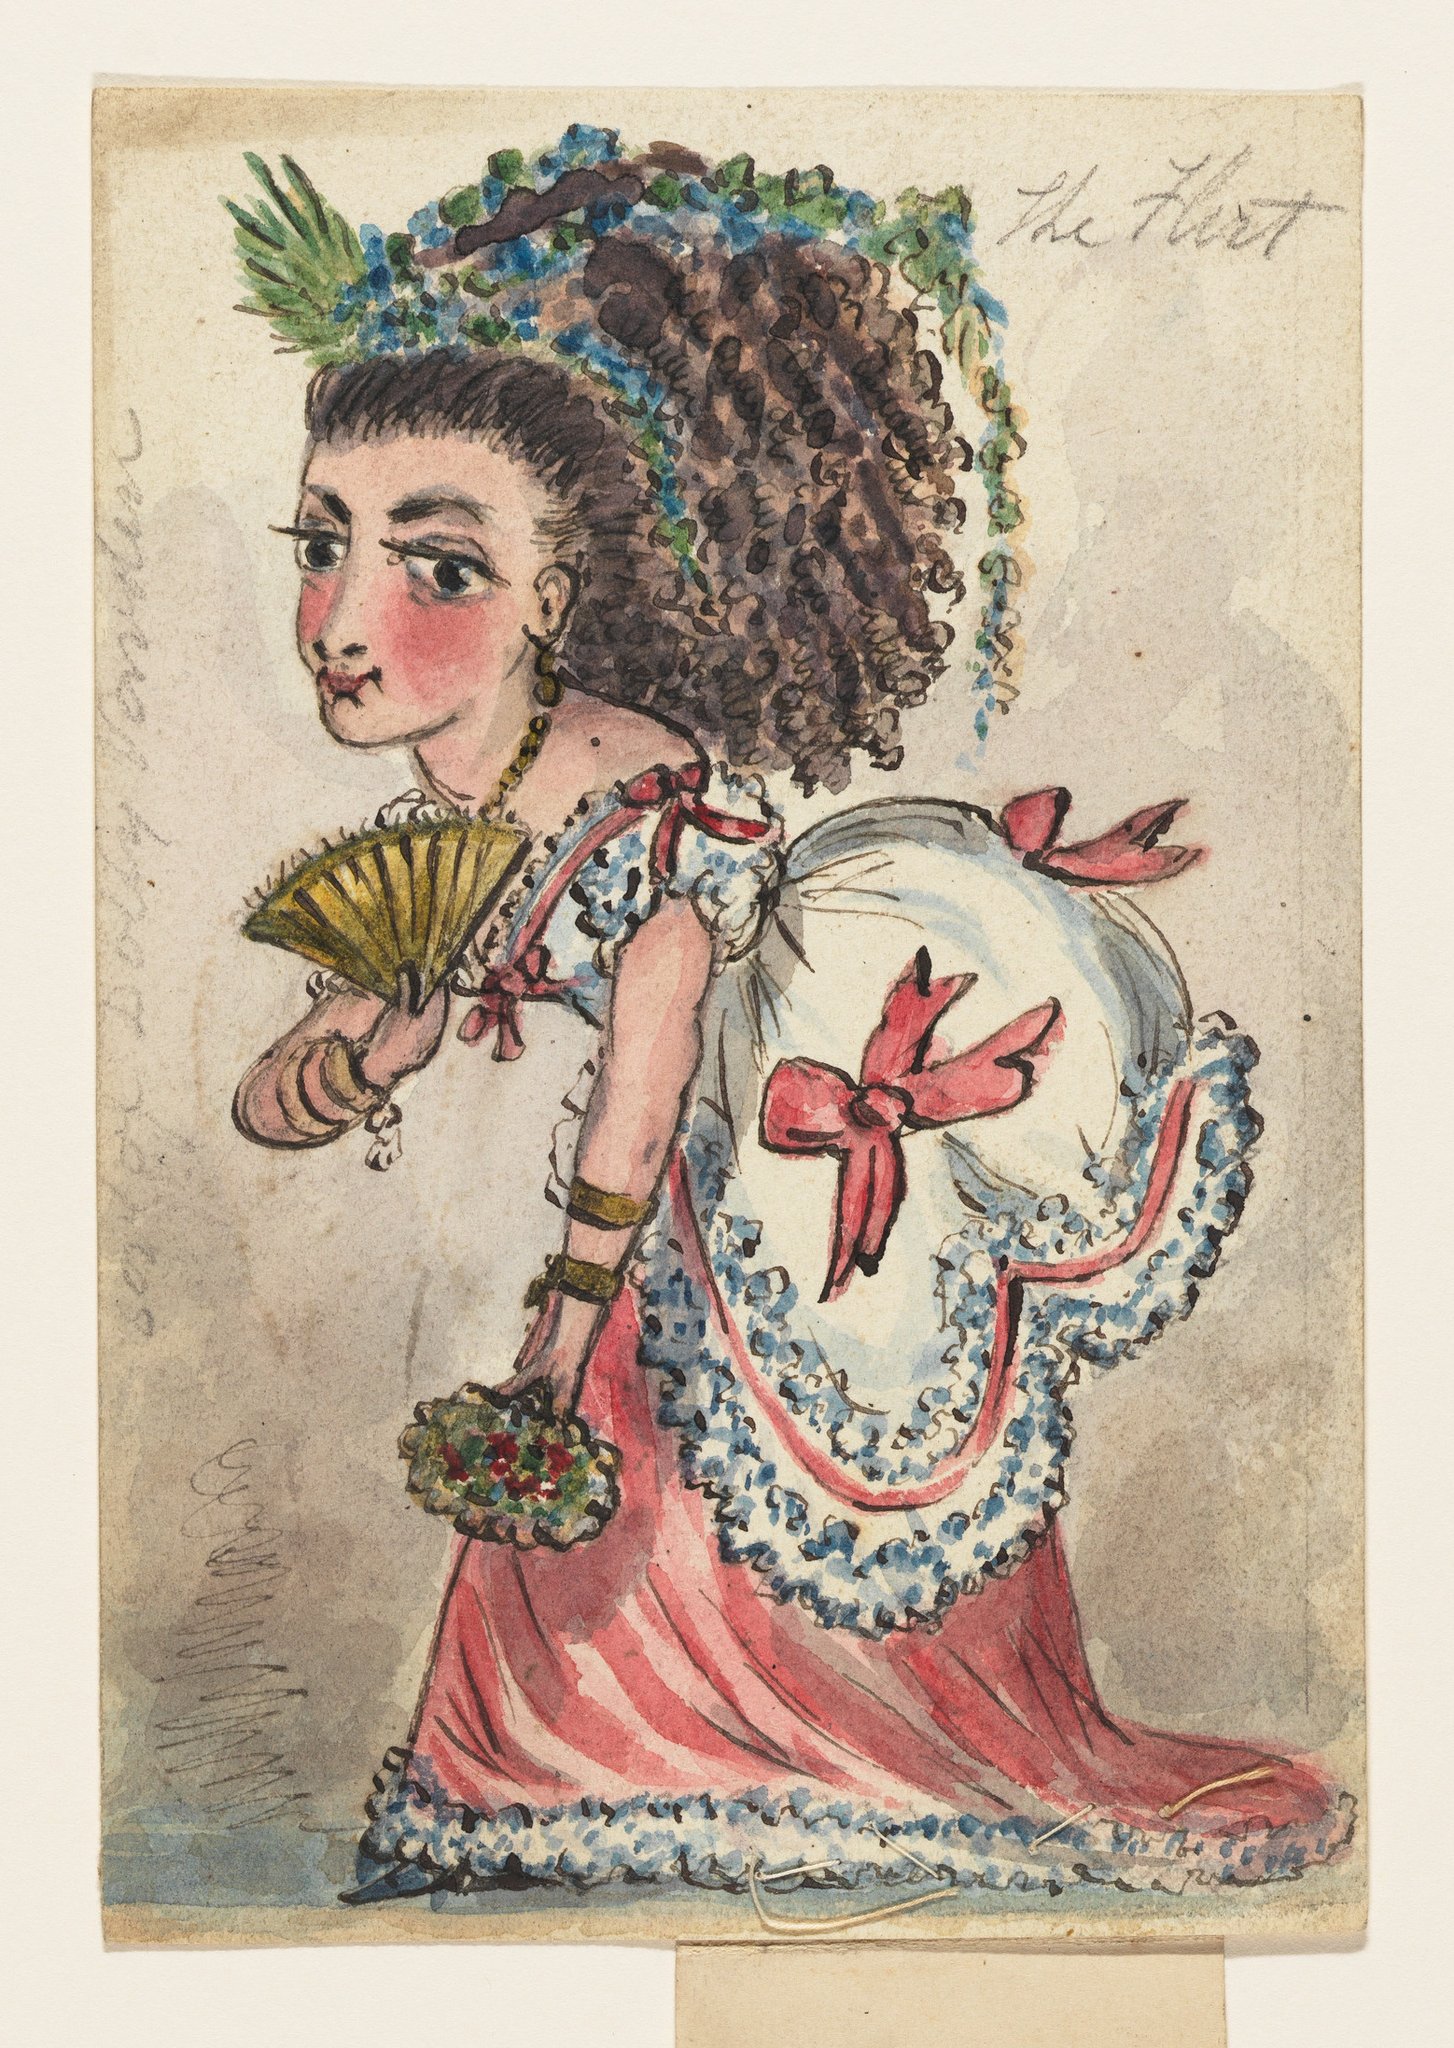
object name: drawing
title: Comic Valentine original illustration: The Flirt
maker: Anonymous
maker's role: artist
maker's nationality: british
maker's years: 1800-1899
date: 1860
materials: ink, watercolor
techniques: hand coloring